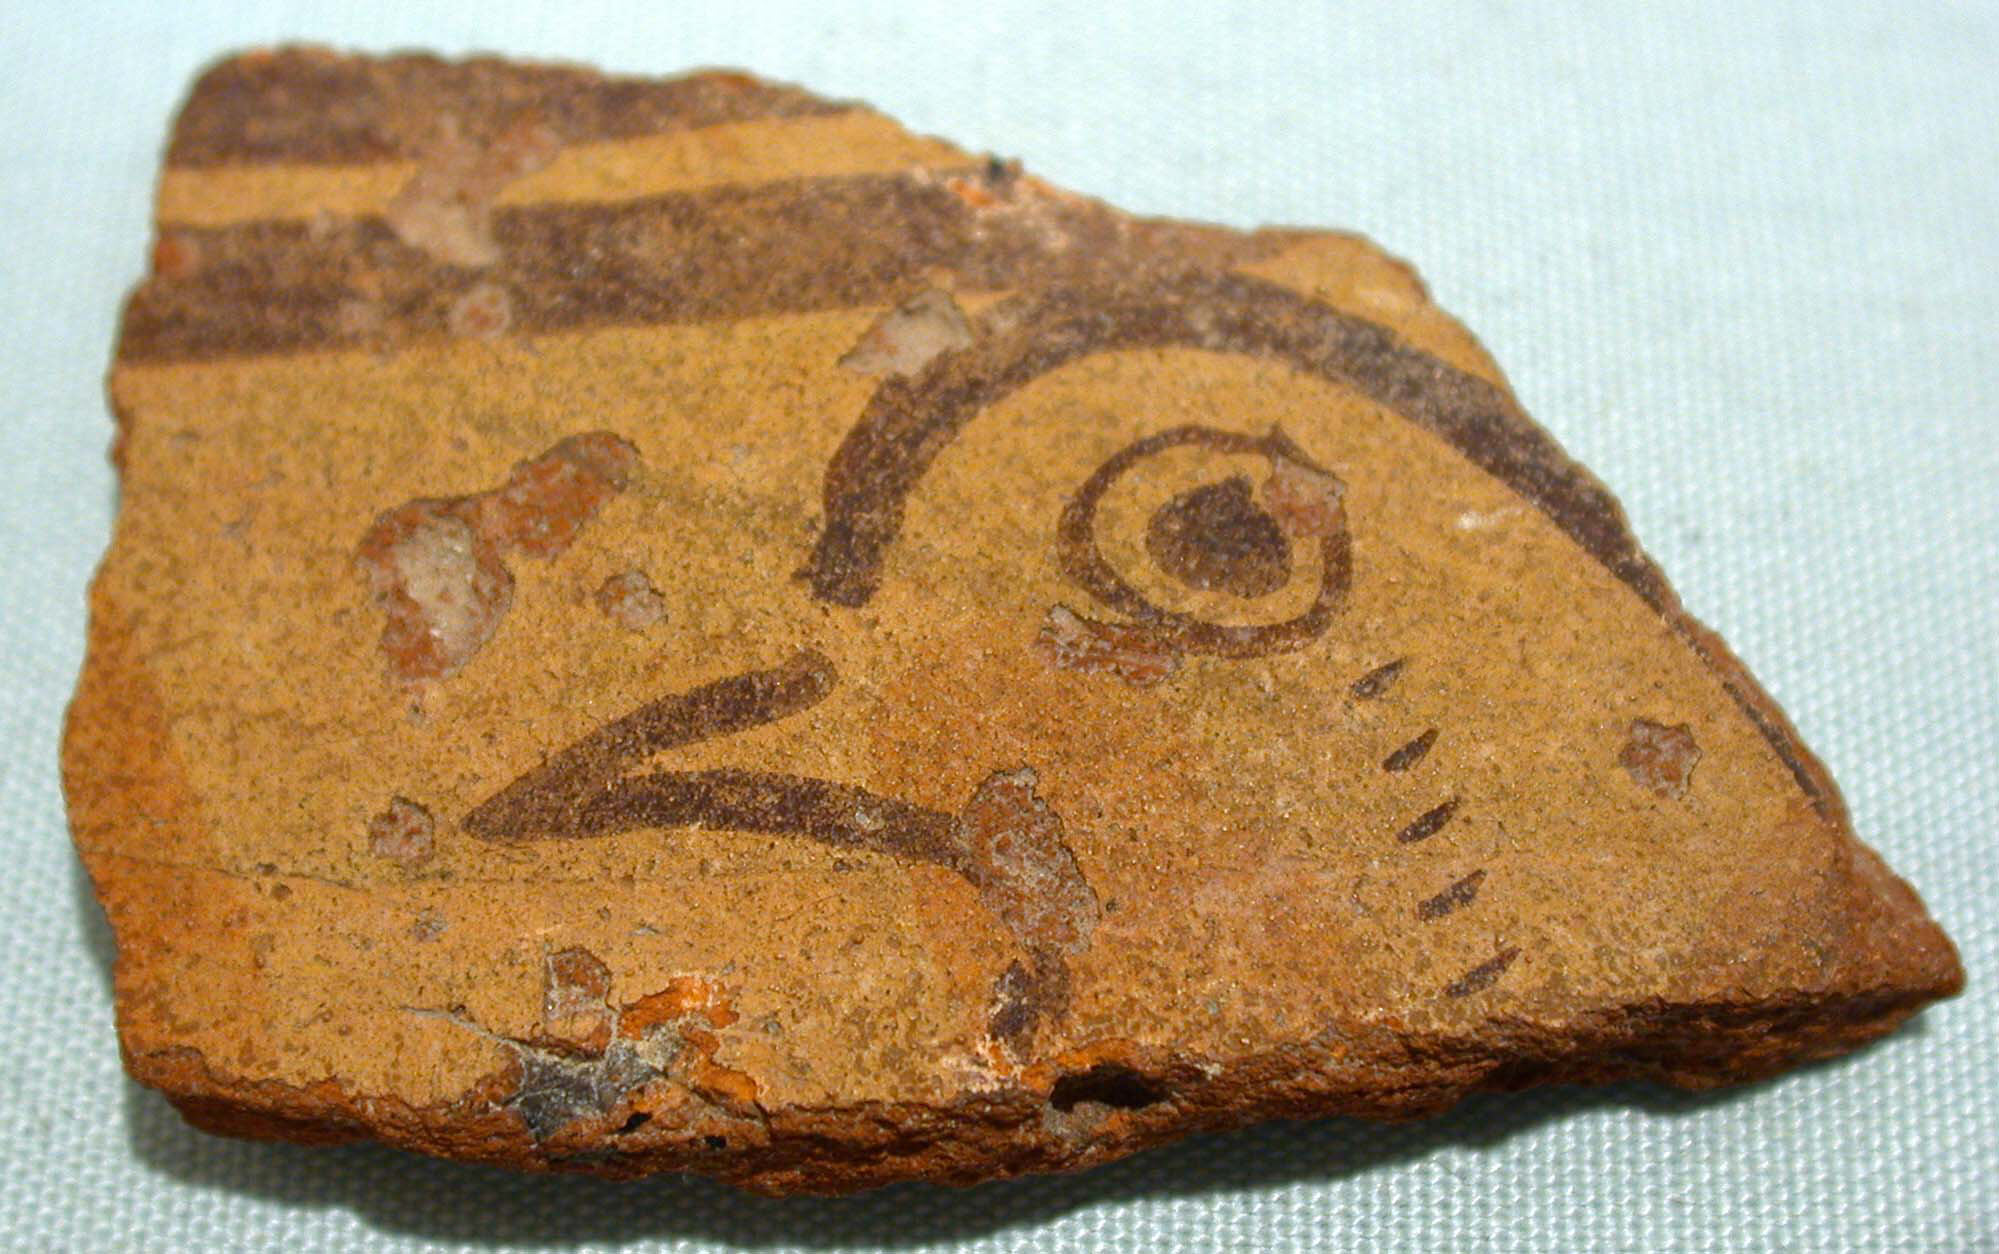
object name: fragment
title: Decorated Jar Fragment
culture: early byzantine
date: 501-1000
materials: terracotta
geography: egypt